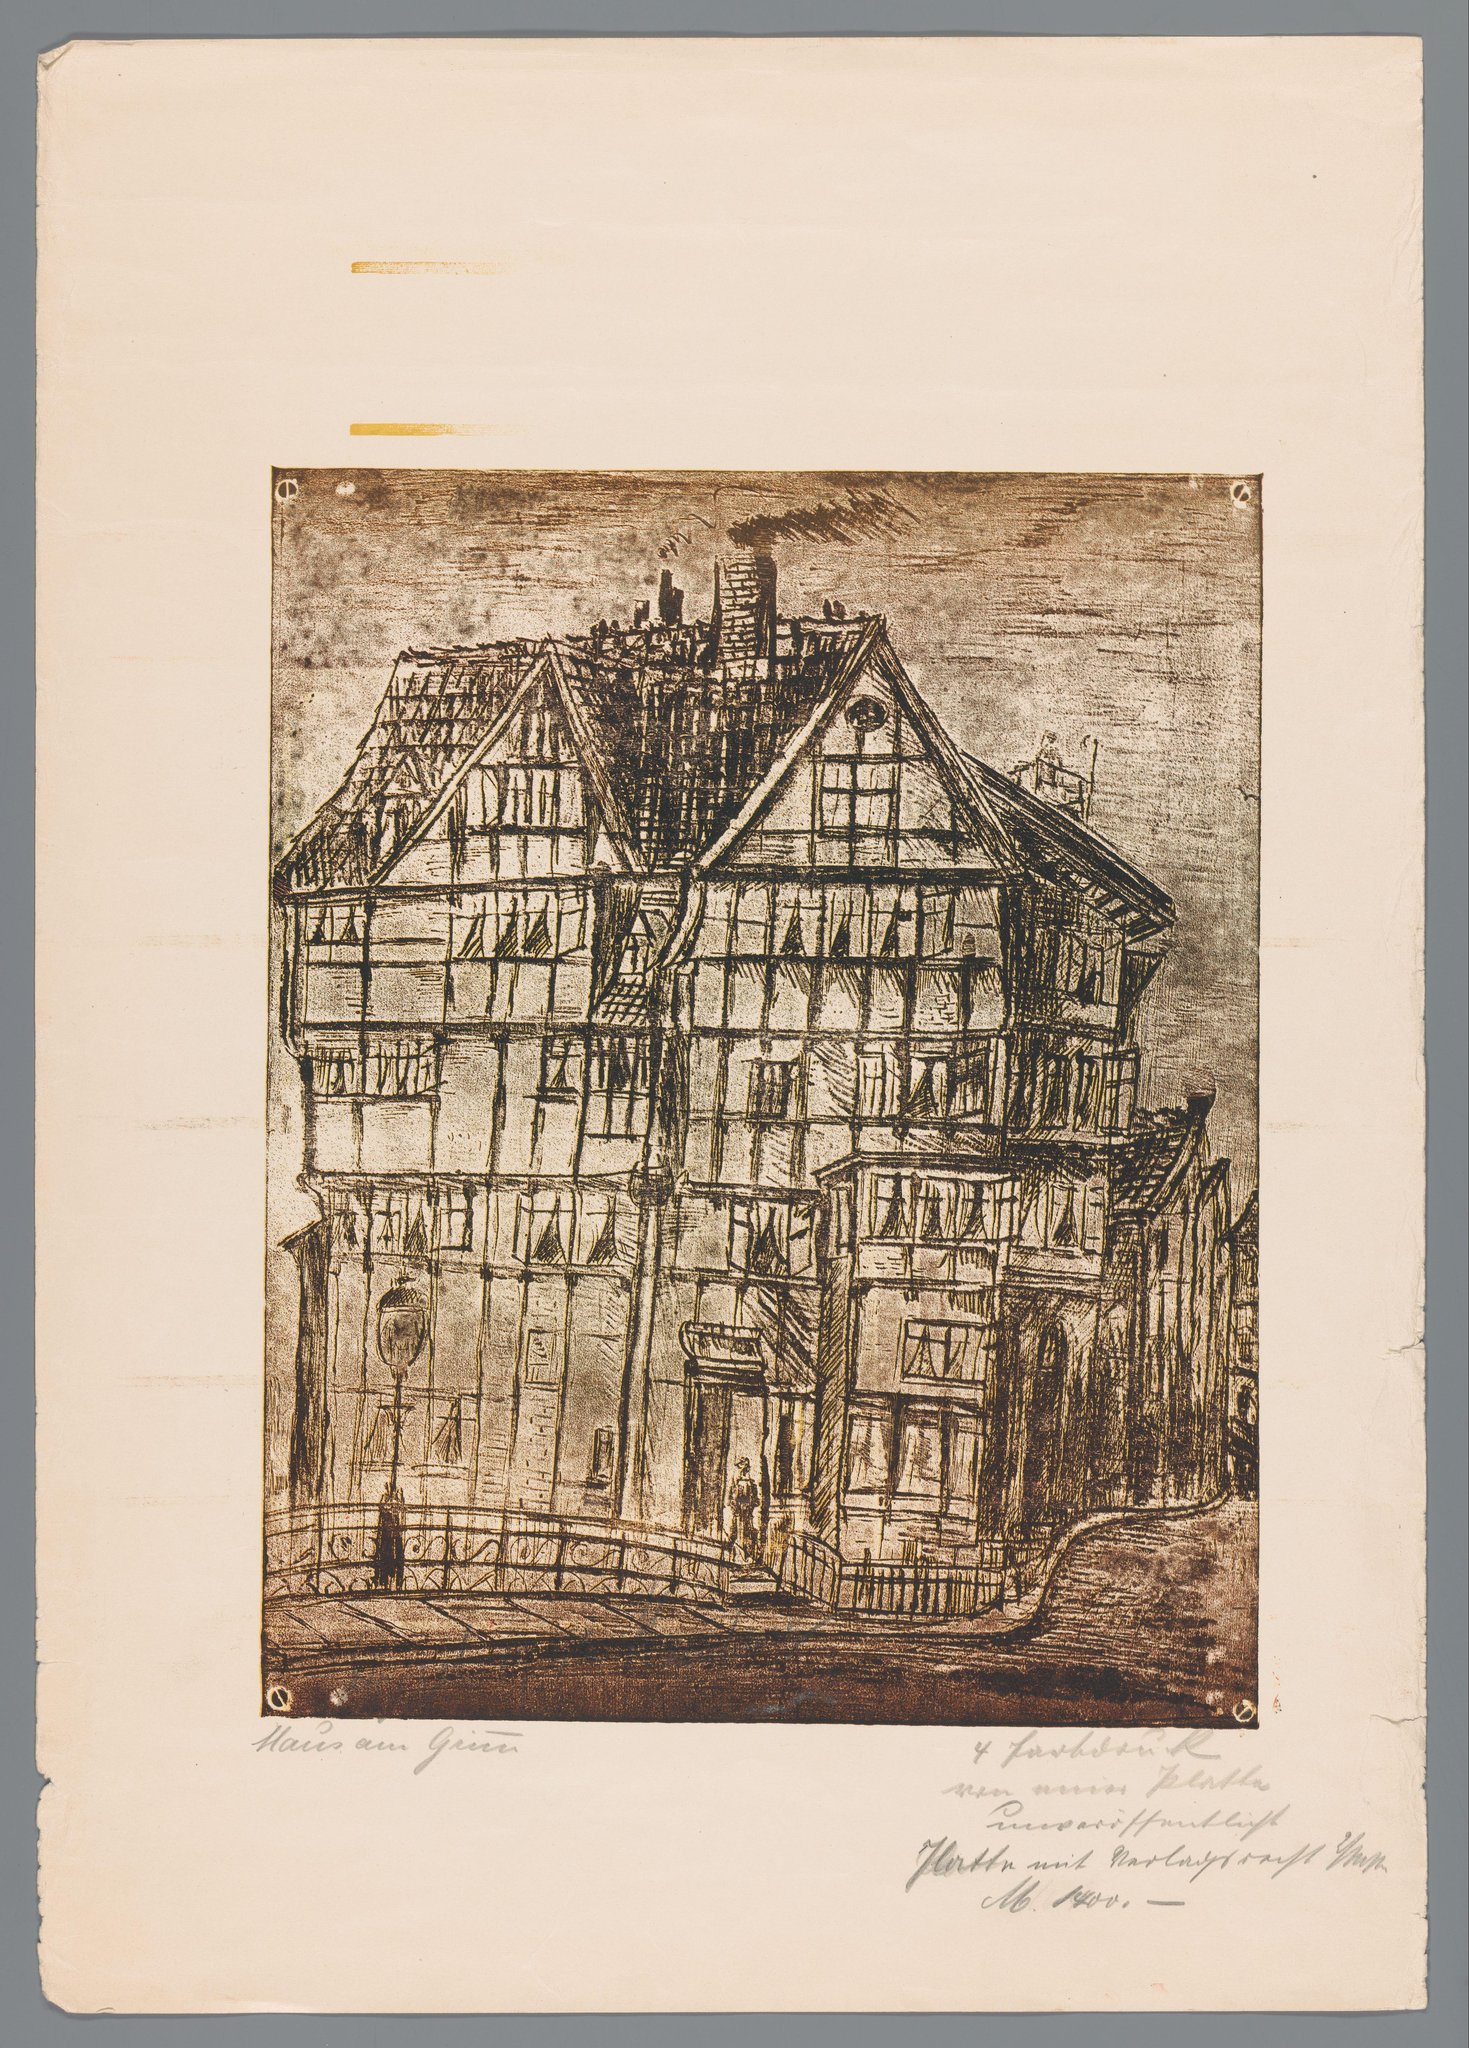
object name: photomechanical print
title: Reproductie van een prent of tekening met gezicht op een oud huis, mogelijk te Greiz in Duitsland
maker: gustav digel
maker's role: publisher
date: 1932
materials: paper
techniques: four-color autotype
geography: hamburg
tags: urban housing, windmill in landscape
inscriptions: collector's mark: Lugt 2228, inscription: ‘4 Farbdruk [...] Platte [...] M. 1400’, signature: ‘Digel 1932 Hamburg’, inscription: ‘Haus am Gr[eiz]’